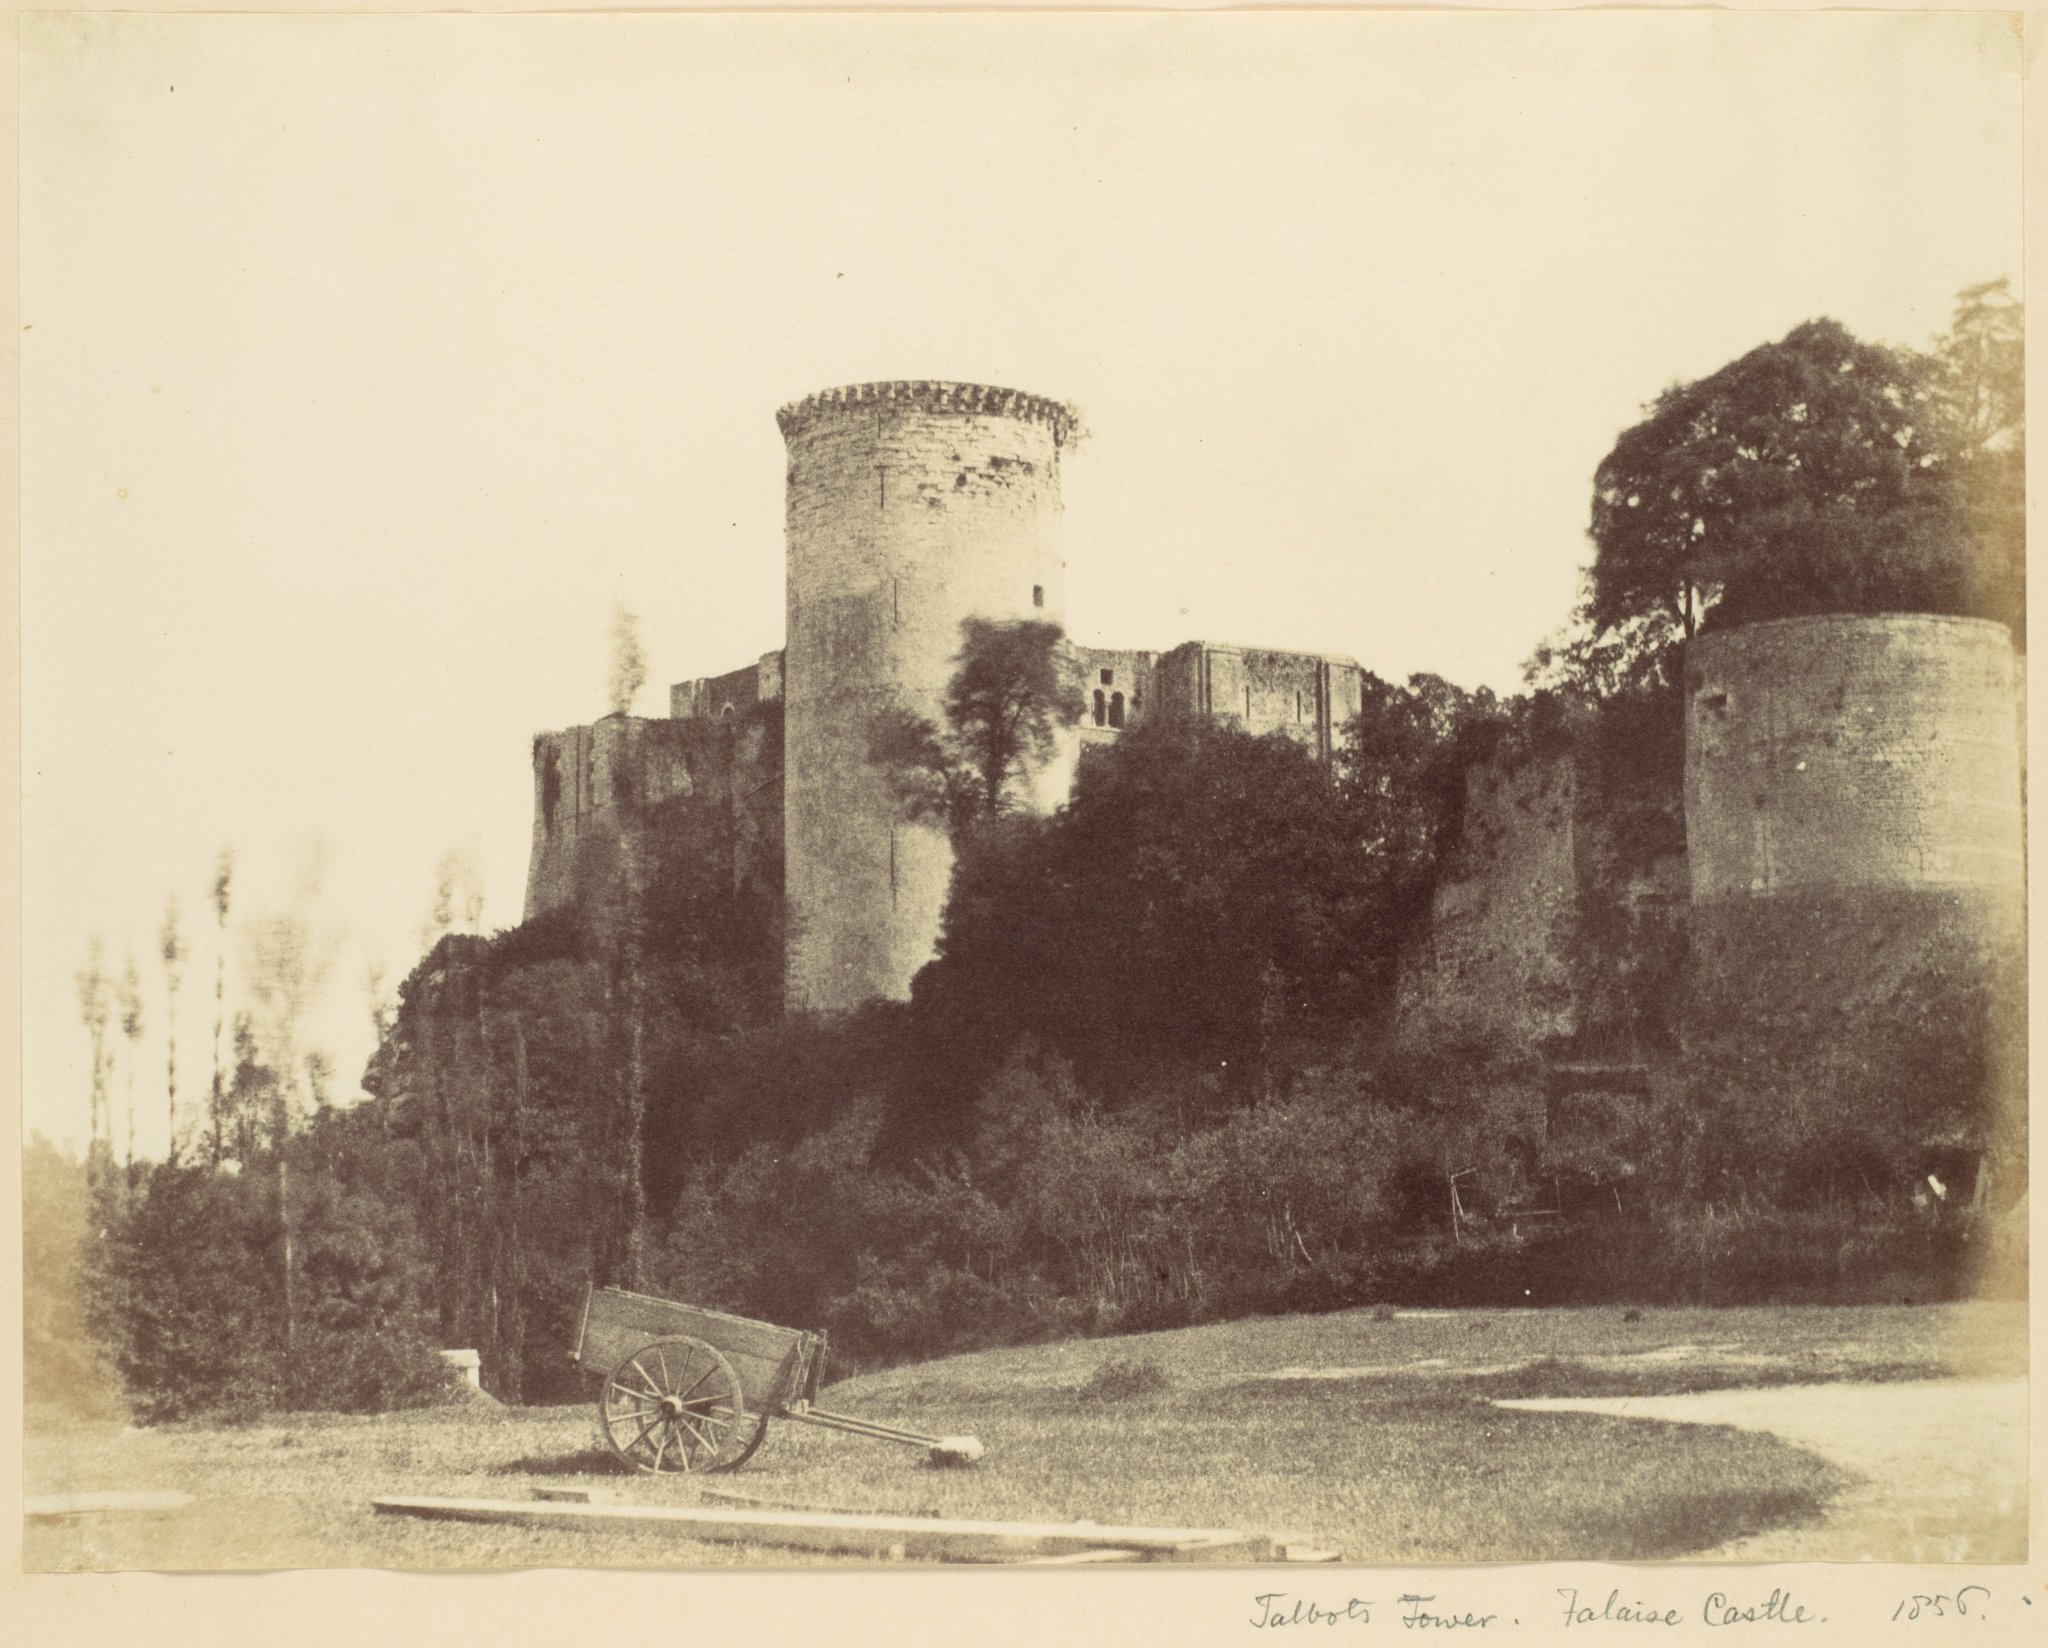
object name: photograph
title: Talbot's Tower, Falaise Castle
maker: alfred capel cure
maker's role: artist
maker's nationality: british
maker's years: 1826-1896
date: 1856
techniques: albumen silver print, paper negative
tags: architecture,castles,towers